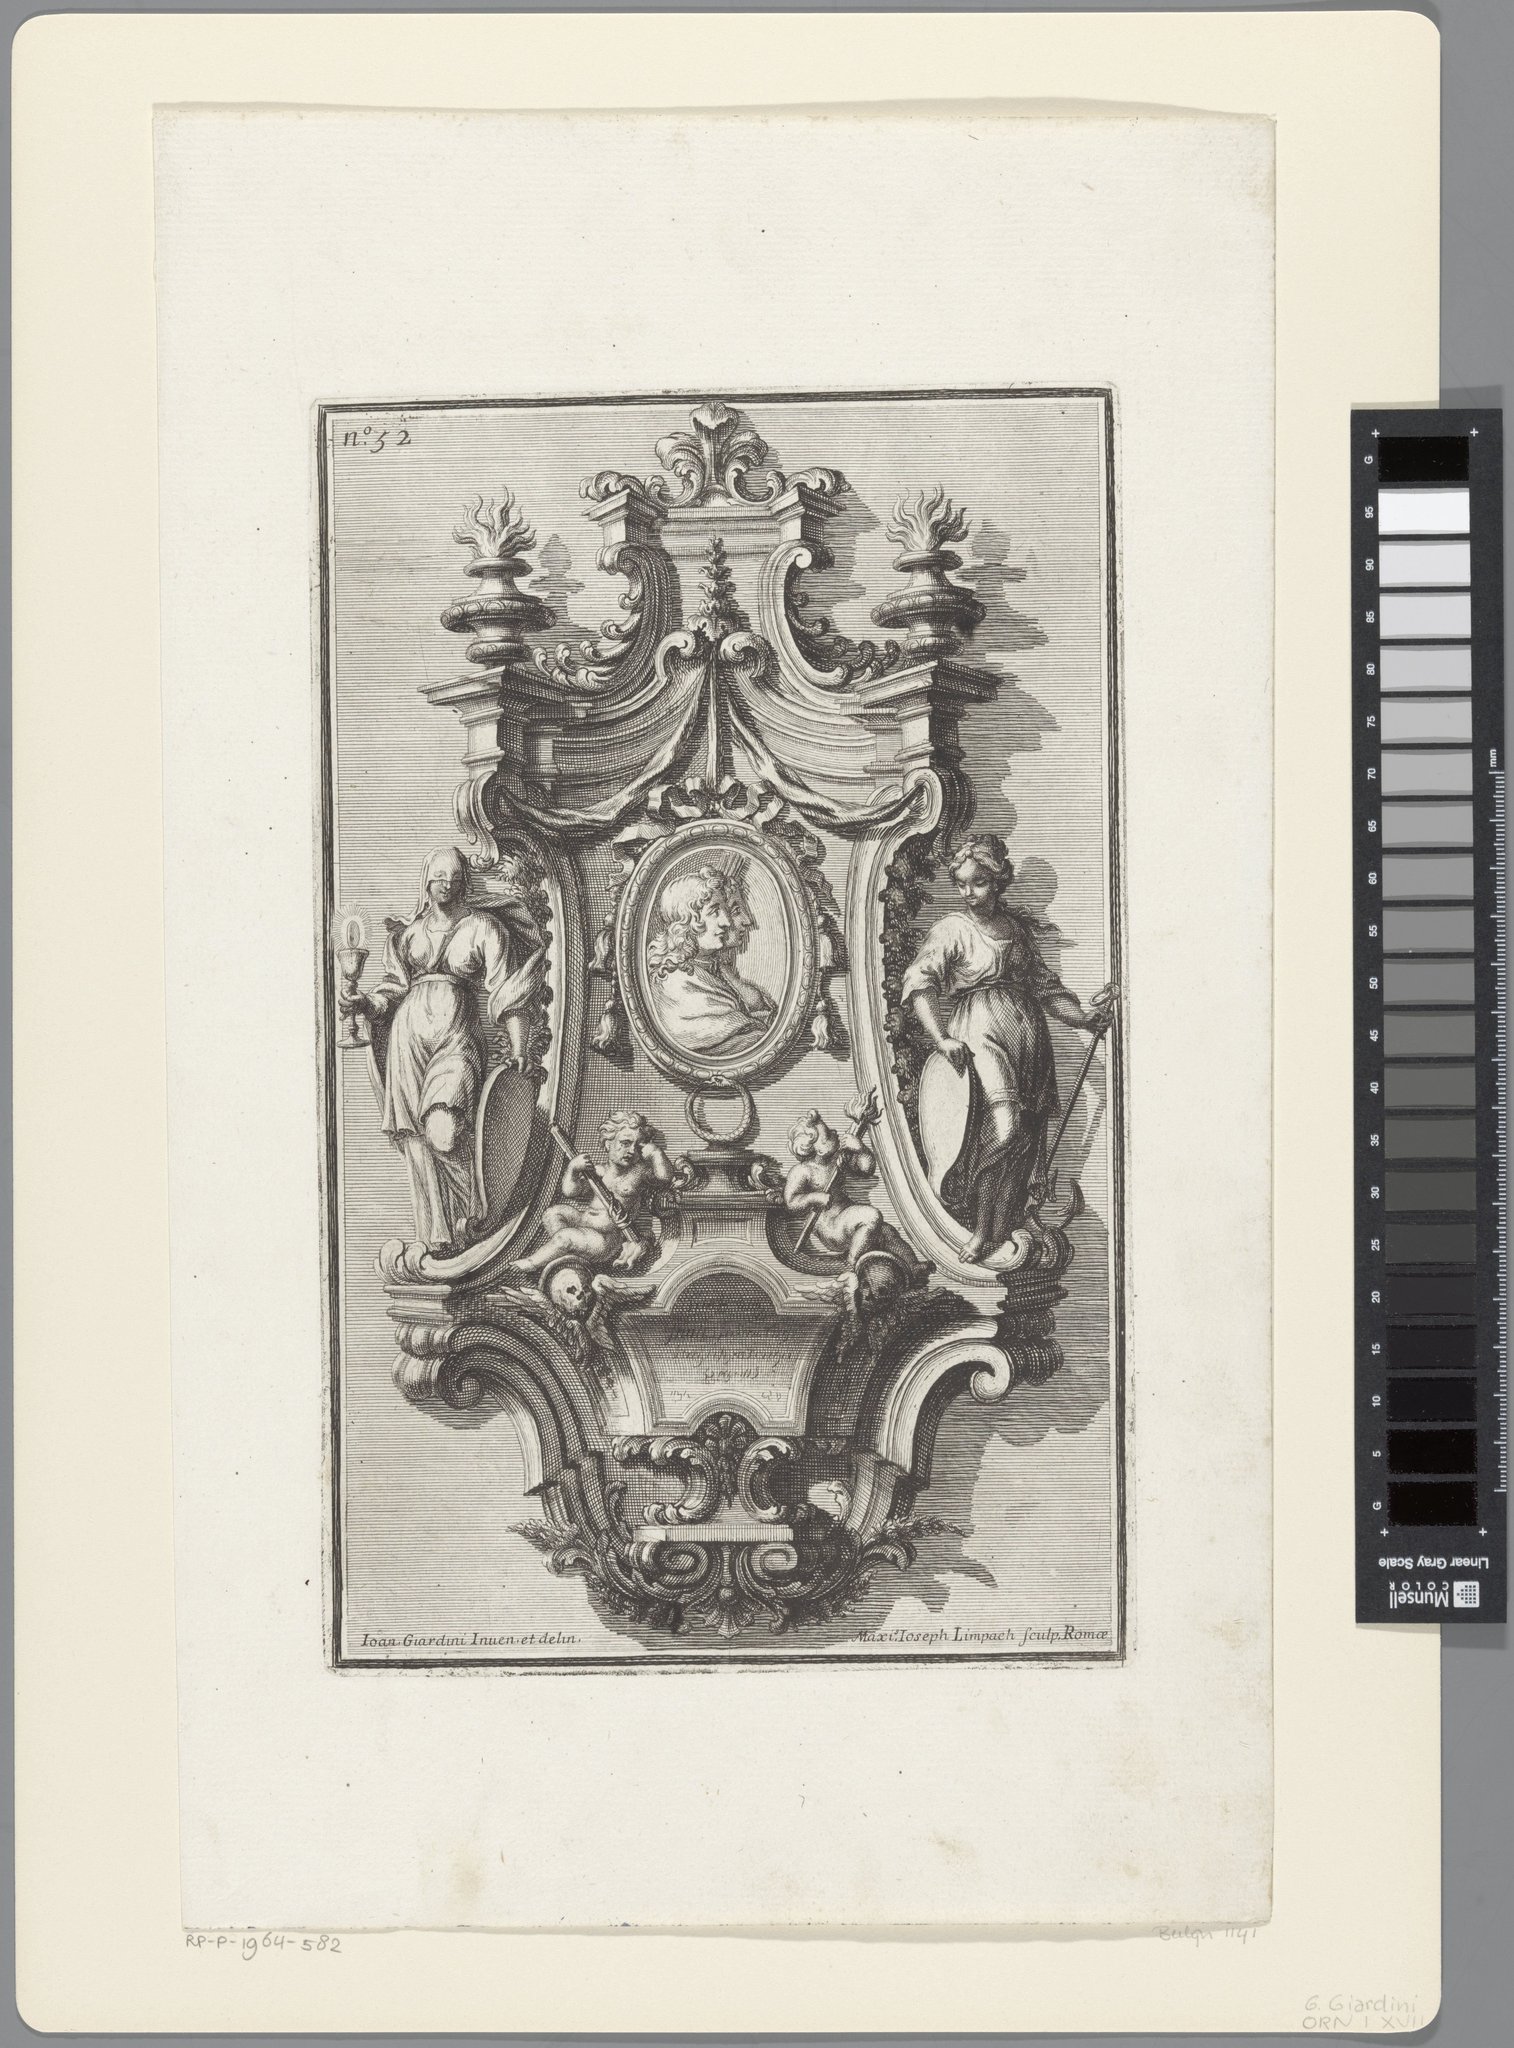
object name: print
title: Diverse kerkelijke voorwerpen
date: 1714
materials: paper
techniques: etching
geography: vatican city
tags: rome, clergyman, clemens xi, ornaments ~ art, faith, 'fides'; 'fede', 'fede catholica', 'fede christiana', 'fede christiana catholica' (ripa) ~ one of the three theological virtues, hope, 'spes'; 'speranza divina e certa' (ripa) ~ one of the three theological virtues, serpent ouroboros, cupids: 'amores', 'amoretti', 'putti'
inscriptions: collector's mark: Lugt 2228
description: Prent maakt deel uit van een reeks van 100 ornamentprenten naar ontwerp van Giovanni Giardini.